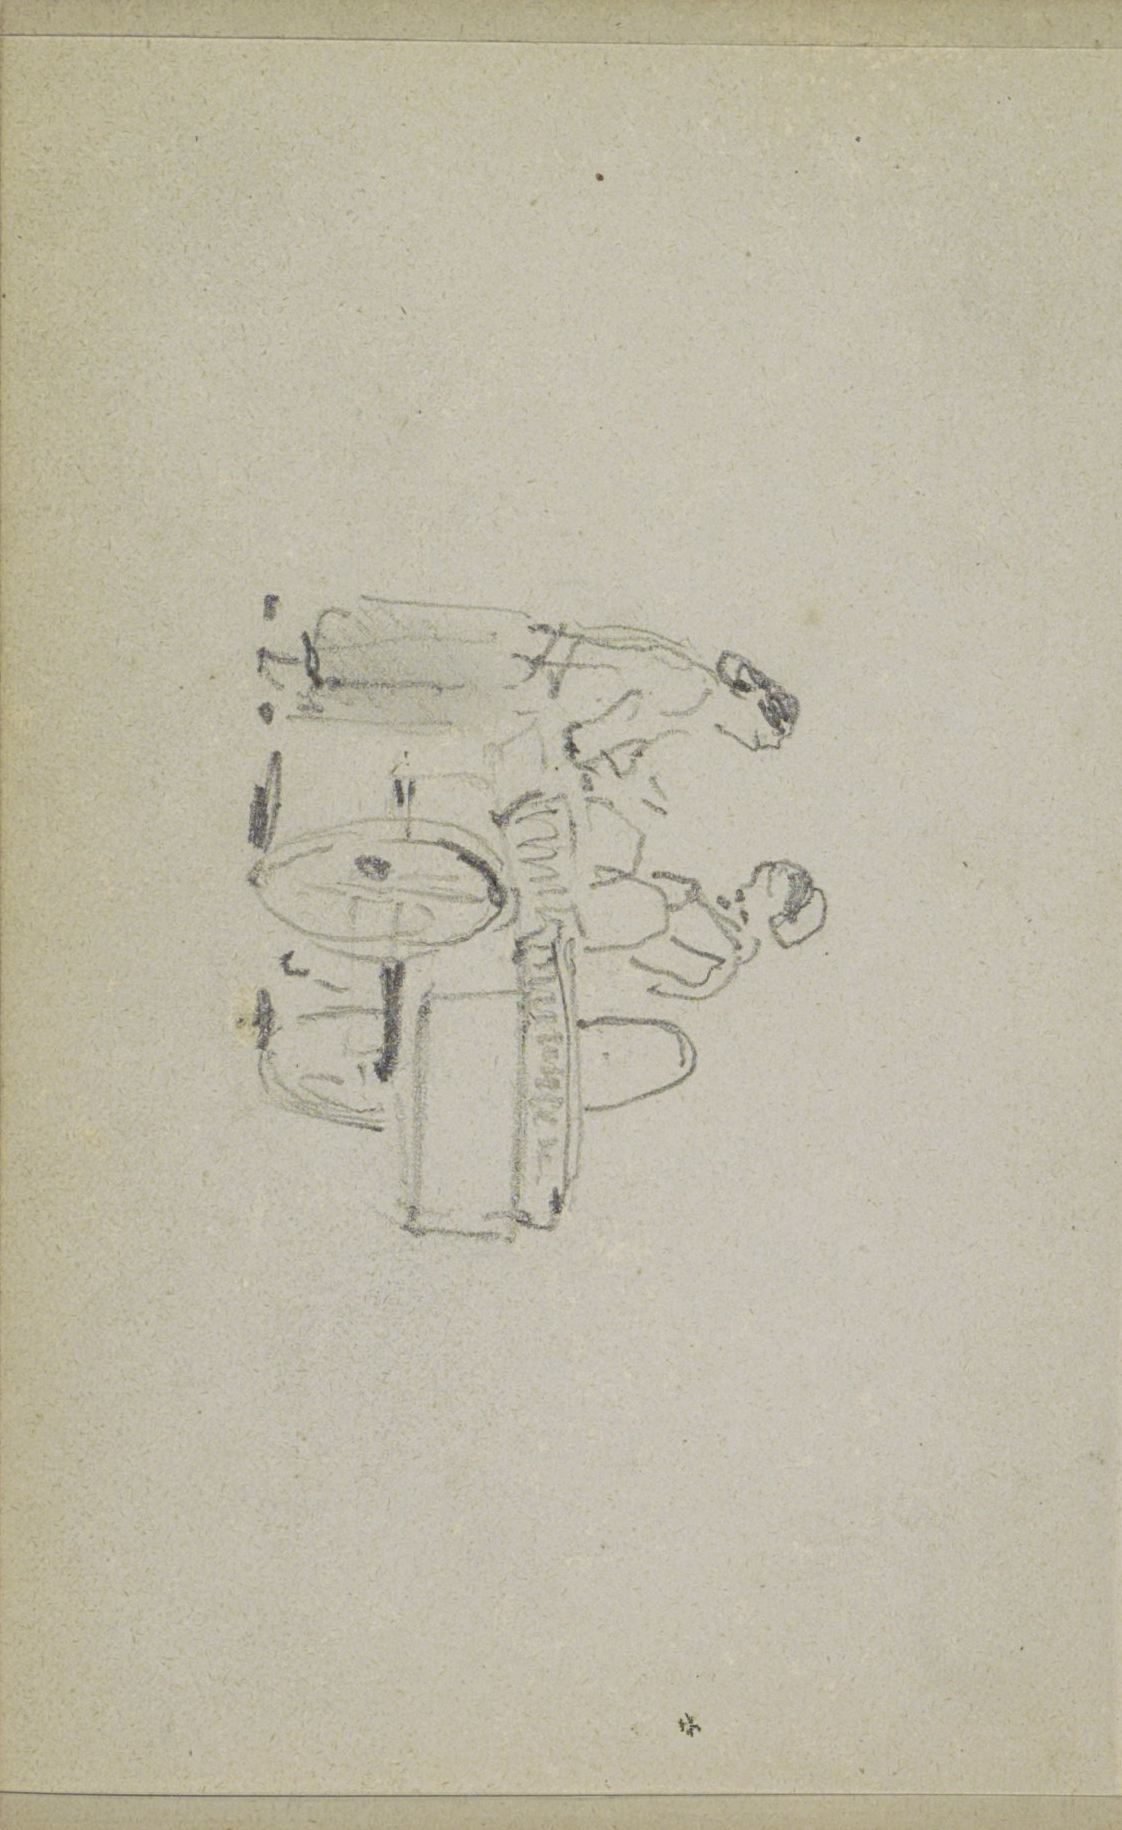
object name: sketchbook leaf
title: Twee figuren bij een handkar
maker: adrianus eversen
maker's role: draughtsman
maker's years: 1818-1897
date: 1828-1897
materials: paper, pencil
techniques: stumping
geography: netherlands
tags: hand-cart, adult woman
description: Twee figuren, waarschijnlijk vrouwen, aan weerszijden van een handkar. Blad 45 verso uit een schetsboek met 58 bladen.